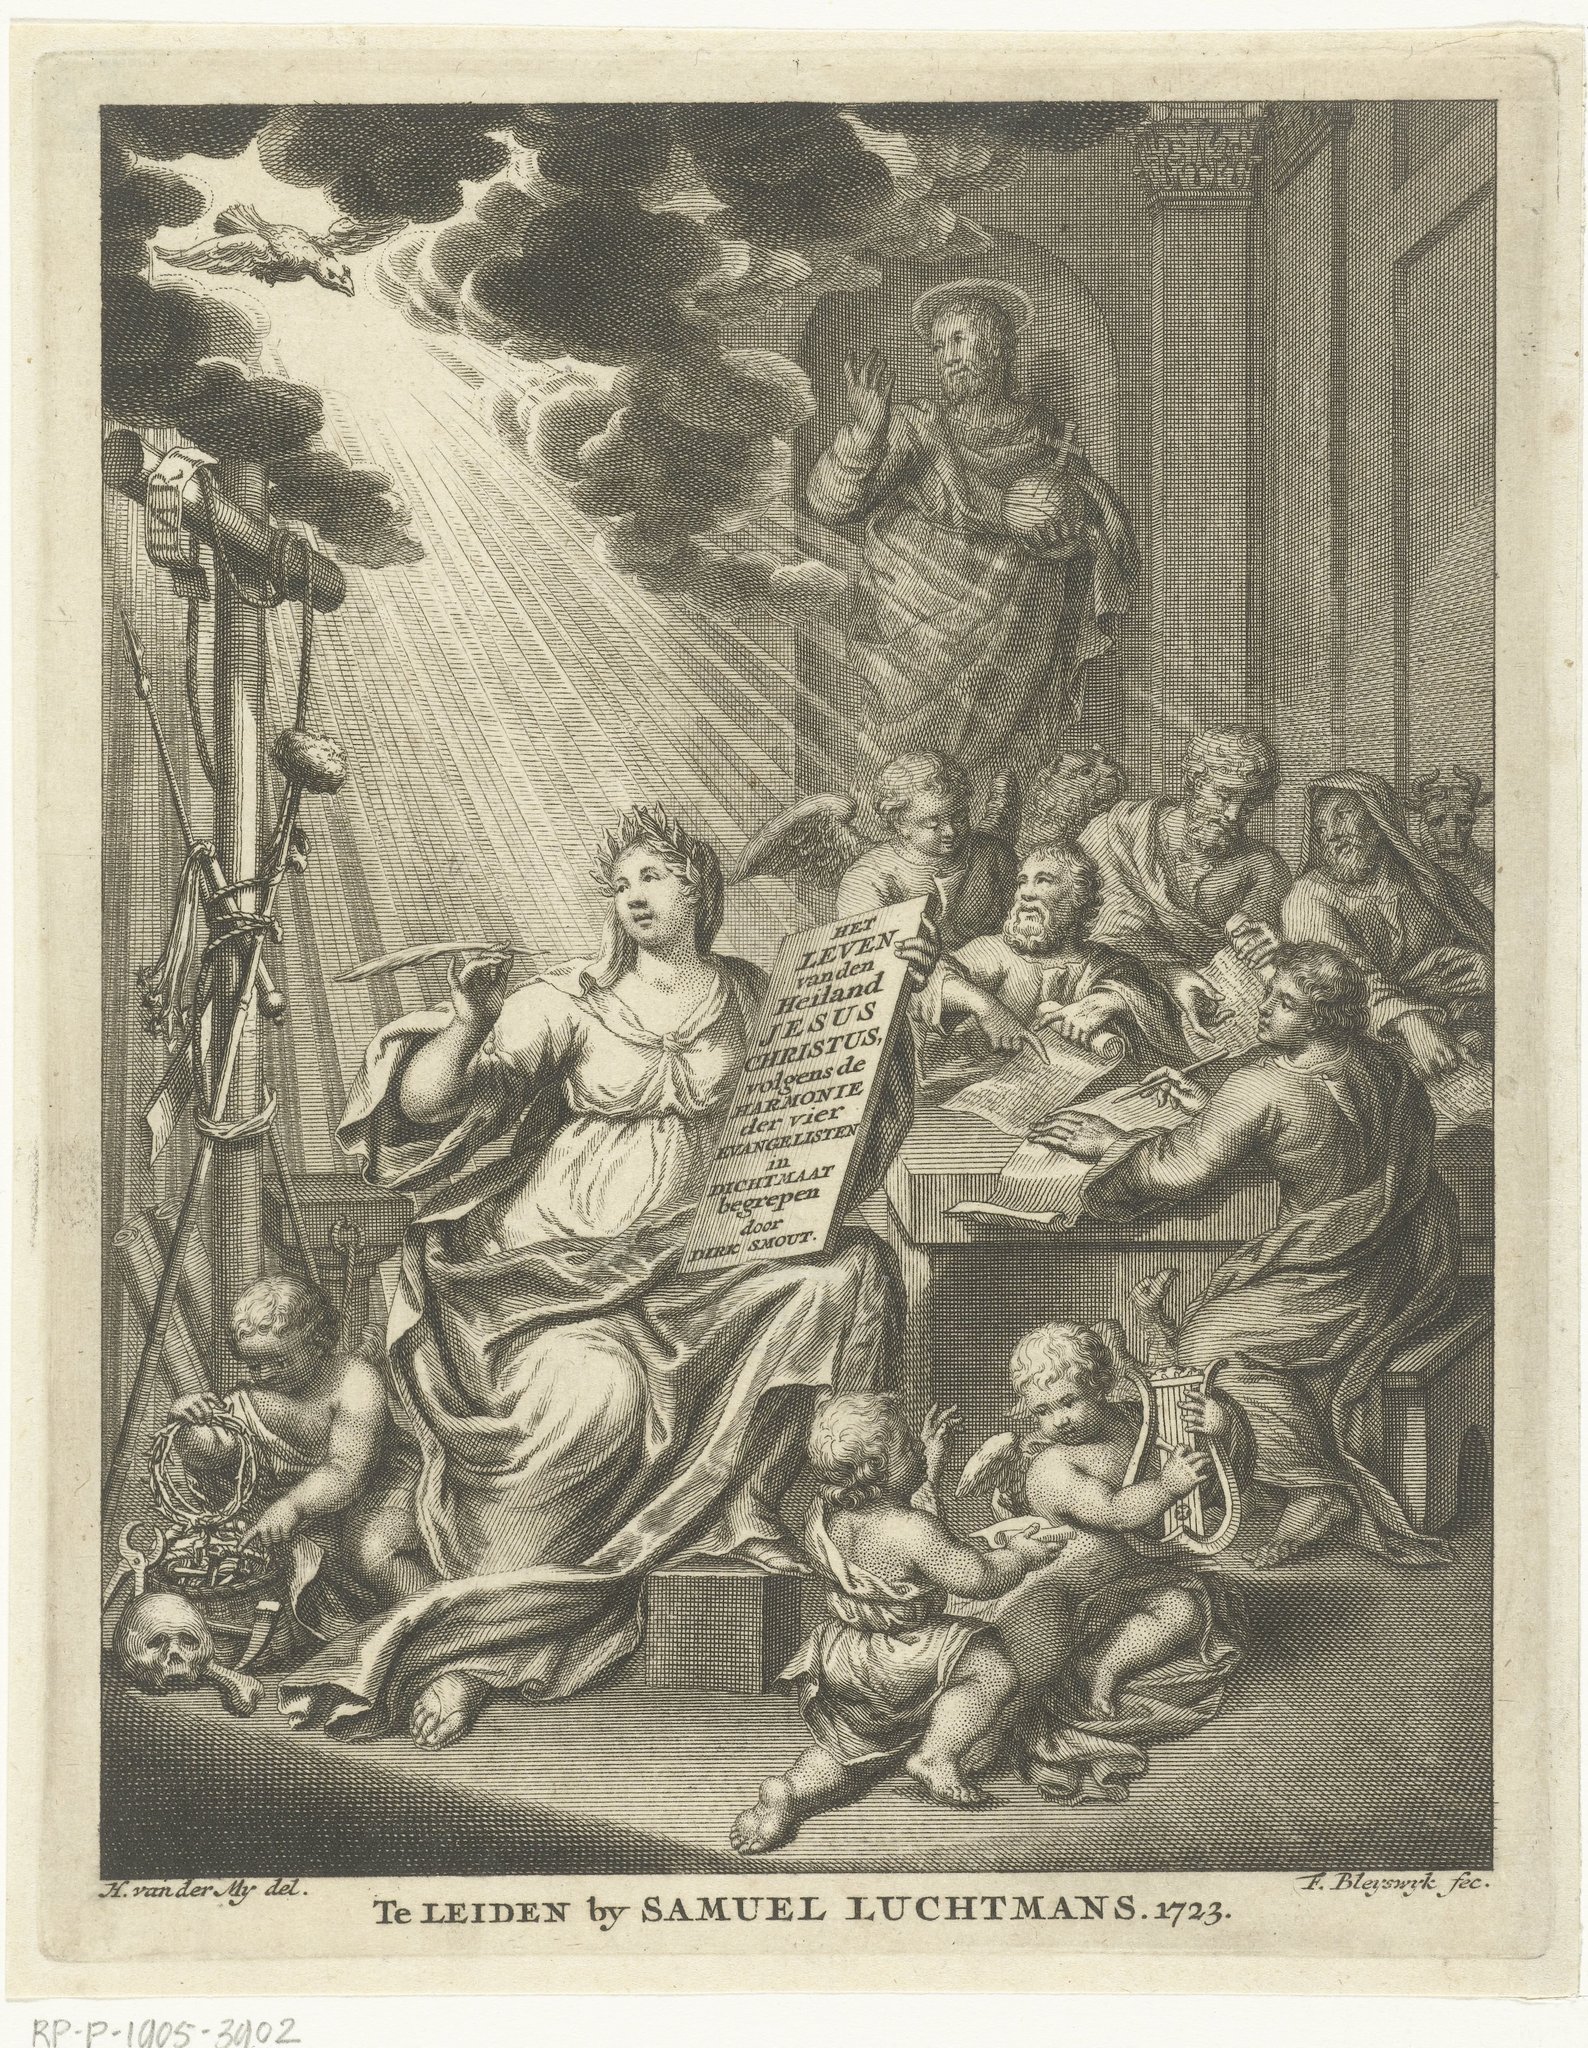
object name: print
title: Titelpagina voor: Dirk Smout, Het leven van den heiland Jesus Christus, volgens de harmonie der vier H. evangelisten, Leiden 1723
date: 1681-1723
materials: paper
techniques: engraving, etching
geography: leiden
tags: christian religion (+ holy ghost (as a dove)), evangelists, usually with books or scrolls (not in biblical context), 'salvator mundi', making a blessing gesture; an orb in his hand or at his feet, 'arma christi'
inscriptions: collector's mark: Lugt 2228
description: Allegorie met vrouwelijke personificatie zittend naast de Arma Christi. De vier evangelisten schrijven aan een tafel ieder hun versie van Christus' leer. In een nis staat een beeld van Christus als Salvator Mundi. Met de verschijning van een duif als symbool van de Heilige Geest straalt een helder licht op de aanwezigen.